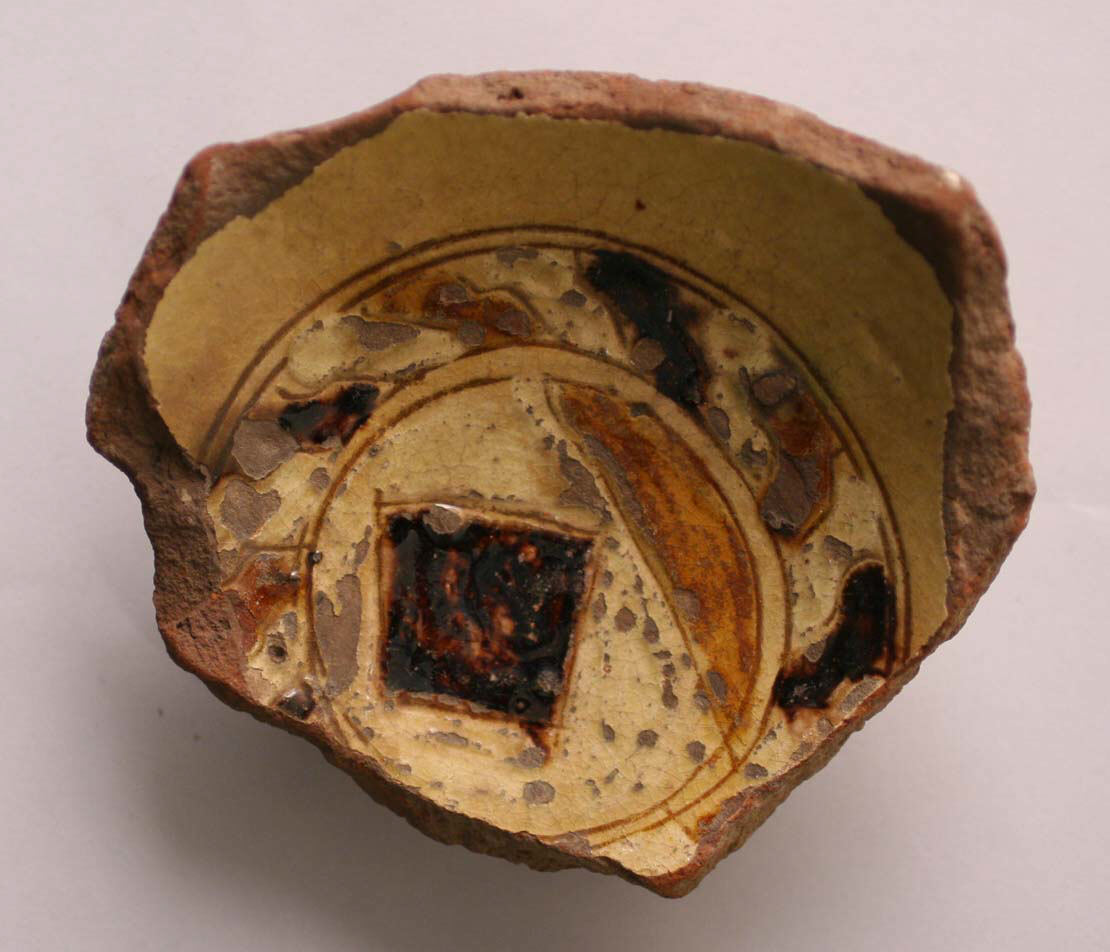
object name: ceramic fragment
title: Fragment of a Bowl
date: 1301-1500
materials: earthenware, glaze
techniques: coloring, incising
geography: egypt